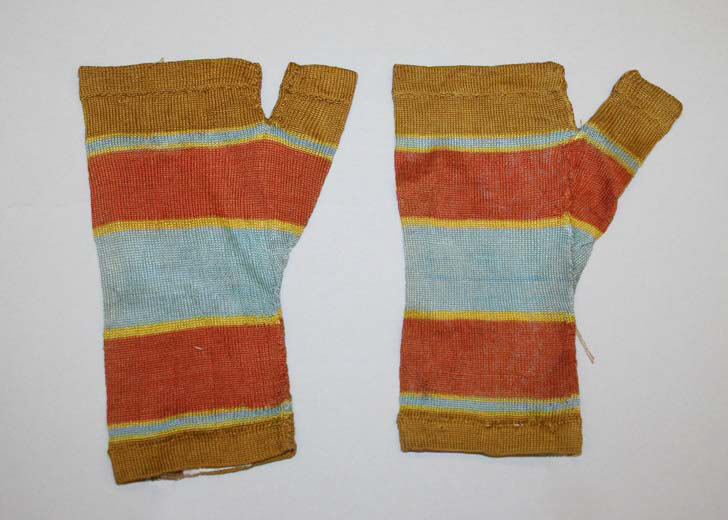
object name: mitt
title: Mitts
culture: italian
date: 1850-1860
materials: silk